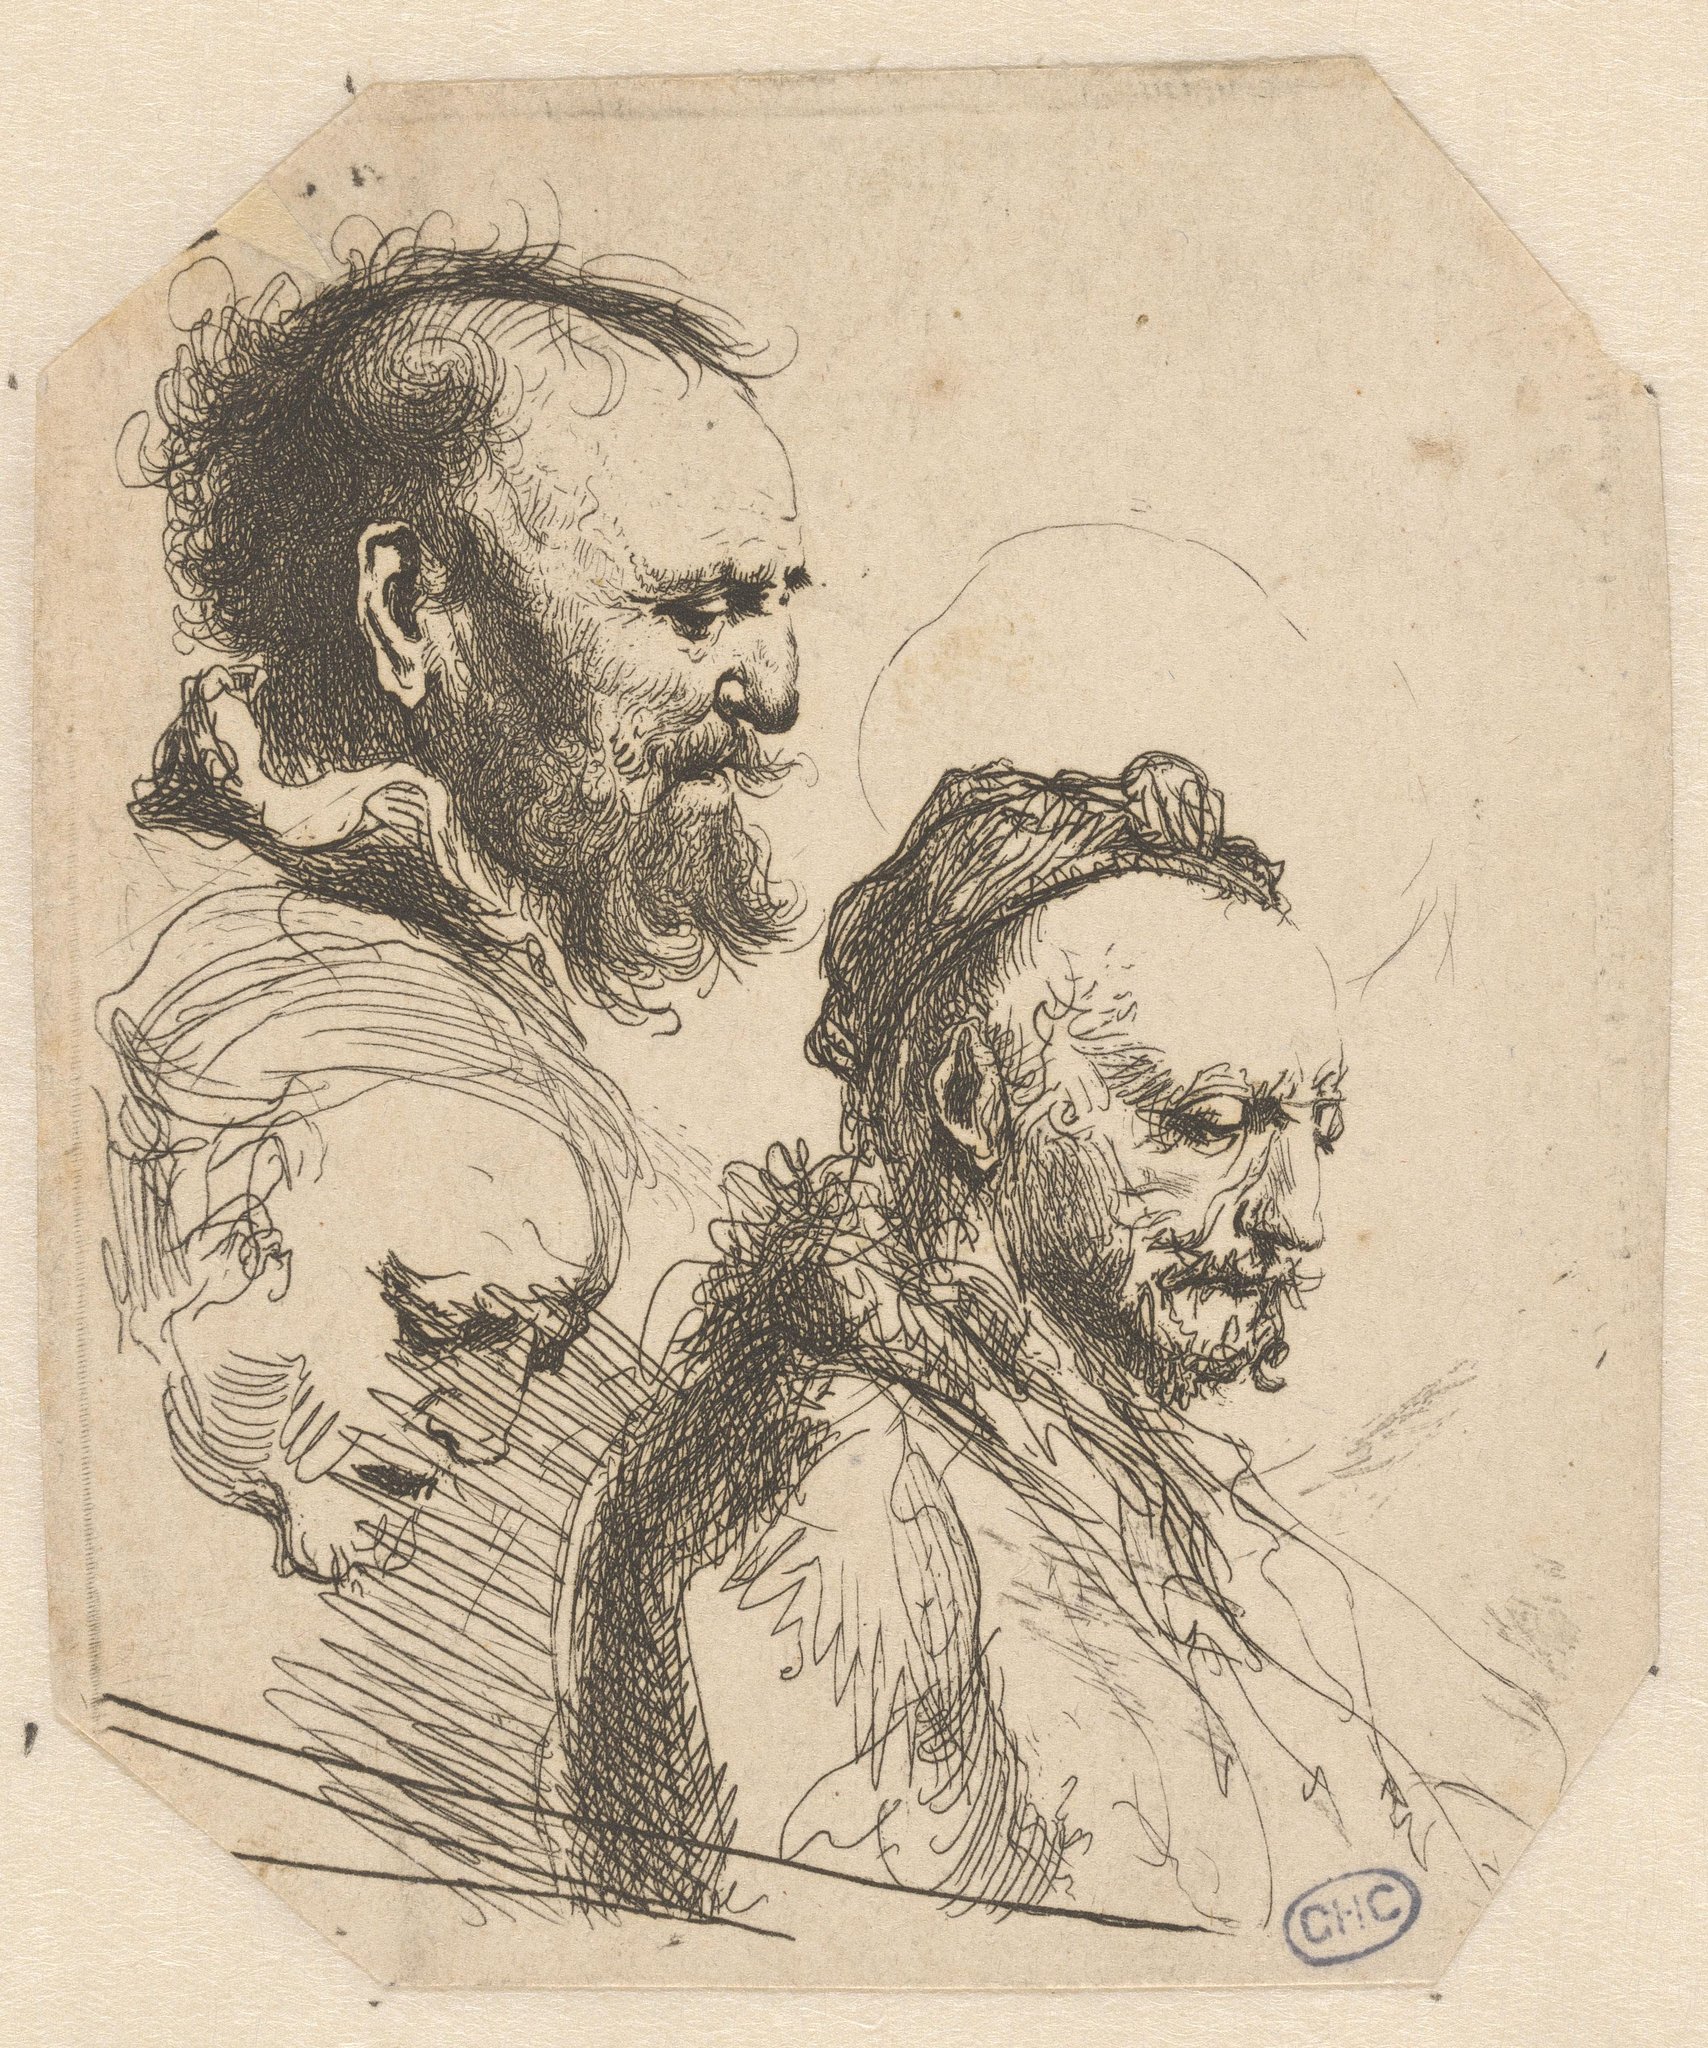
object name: print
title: Three studies of old men's heads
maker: ignace-joseph de claussin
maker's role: print maker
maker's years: 1766-1844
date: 1802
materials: paper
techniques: etching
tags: drawing, sketch, old man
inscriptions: collector's mark: Lugt 1138c, collector's mark: Lugt 2228, collector's mark: Lugt 2760, collector's mark: Lugt 1159a